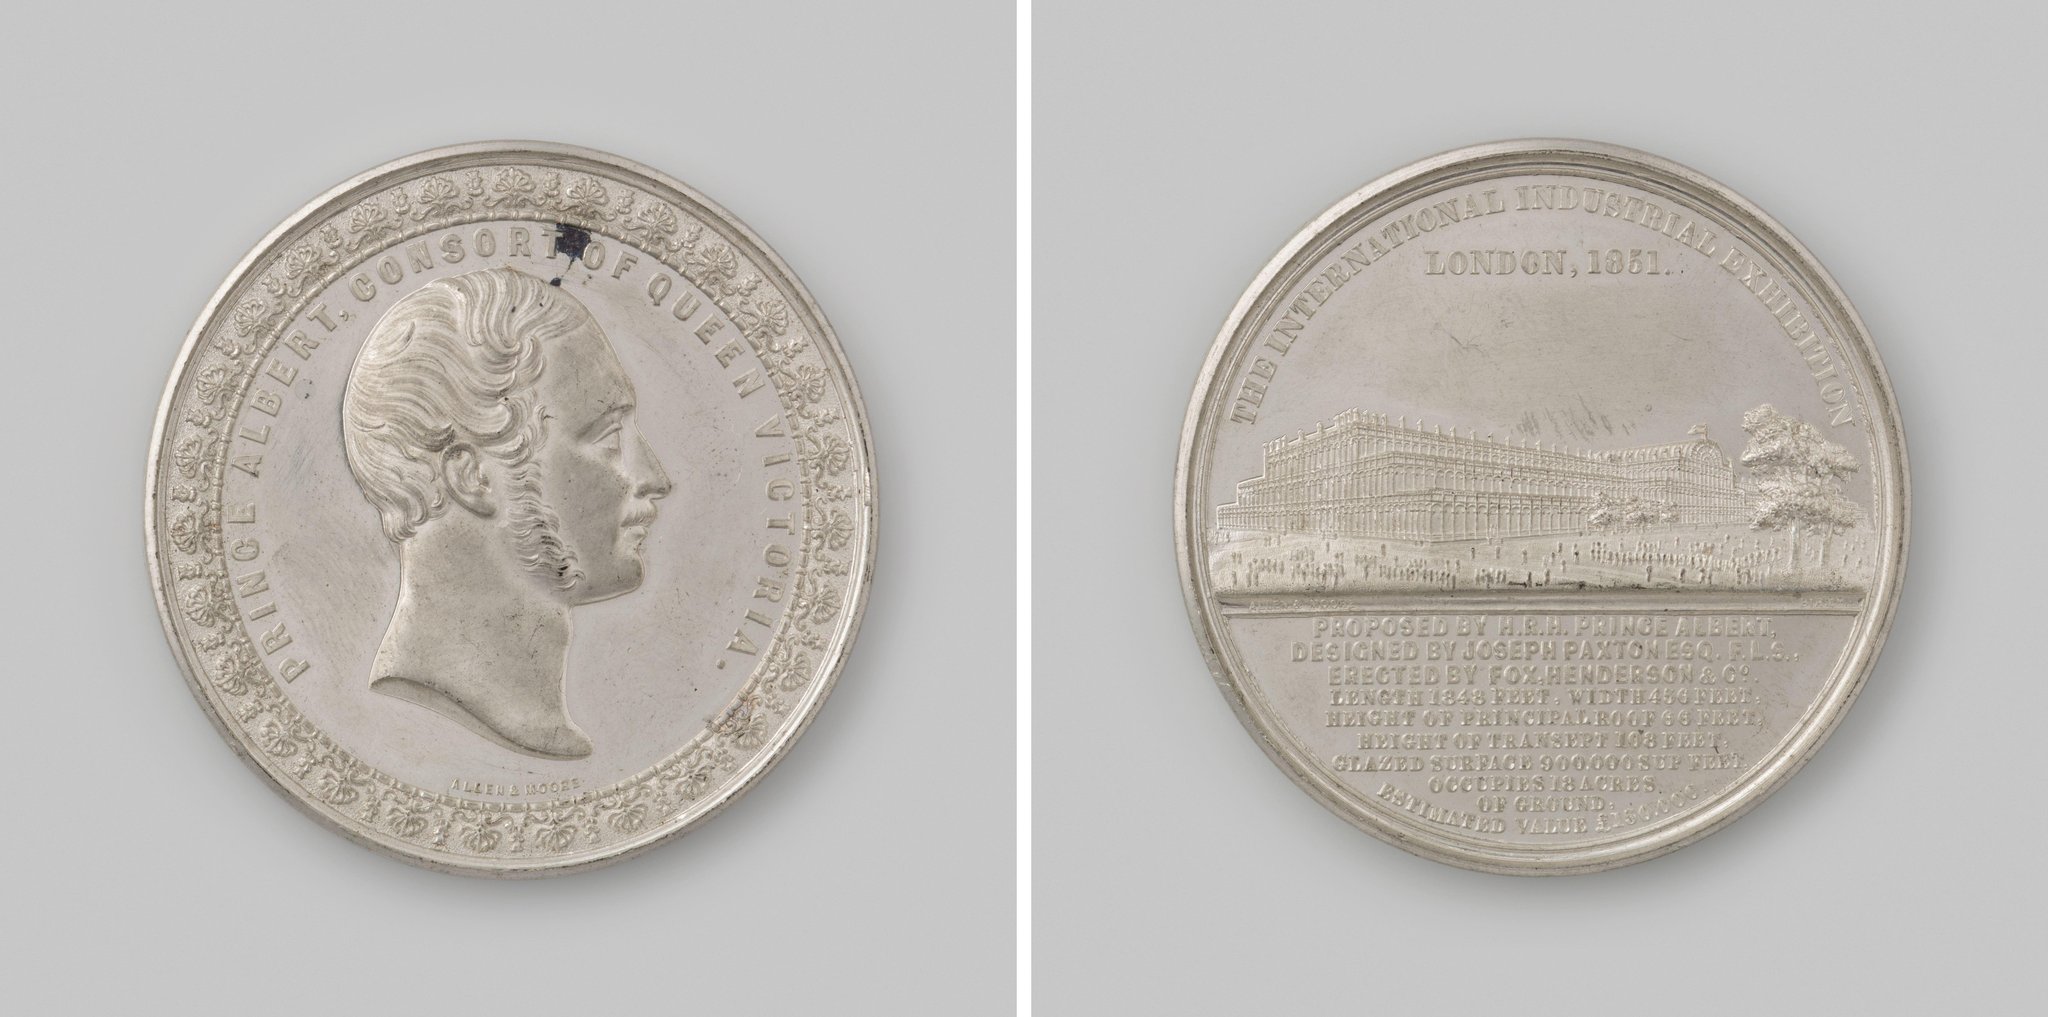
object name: history medal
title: Opening van het gebouw voor de Internationale Tentoonstelling te Londen 1851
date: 1851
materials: tin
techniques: striking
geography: birmingham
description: Tinnen penning, op de voorzijde het portret van Prins Albert naar rechts met omschrift binnen een versierde rand, op de keerzijde twee regels tekst, het tentoonstellingsgebouw en tien regels afsnedetekst.